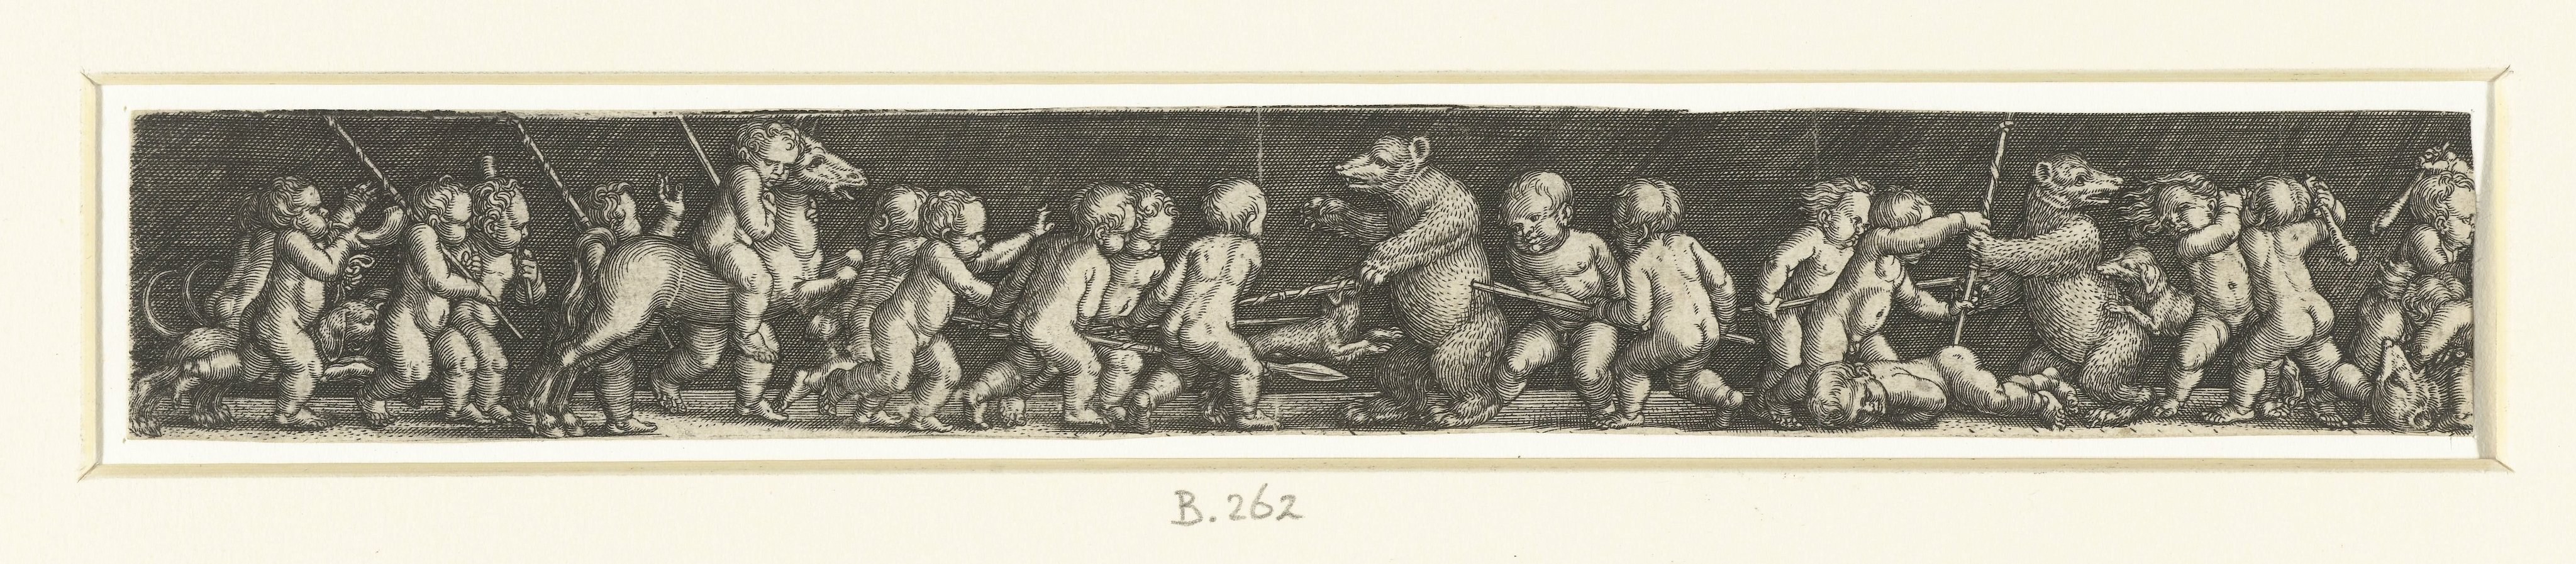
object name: print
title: Fries met kinderen die beren vangen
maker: heinrich aldegrever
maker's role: draughtsman, print maker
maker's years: 1502-1561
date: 1535-1537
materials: paper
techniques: engraving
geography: germany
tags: child (+ more than eight persons), hunting, chase, beasts of prey, predatory animals: bear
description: Fries met een grote groep naakte kinderen met lansen drie beren vangen. Rechterzijde afgesneden.